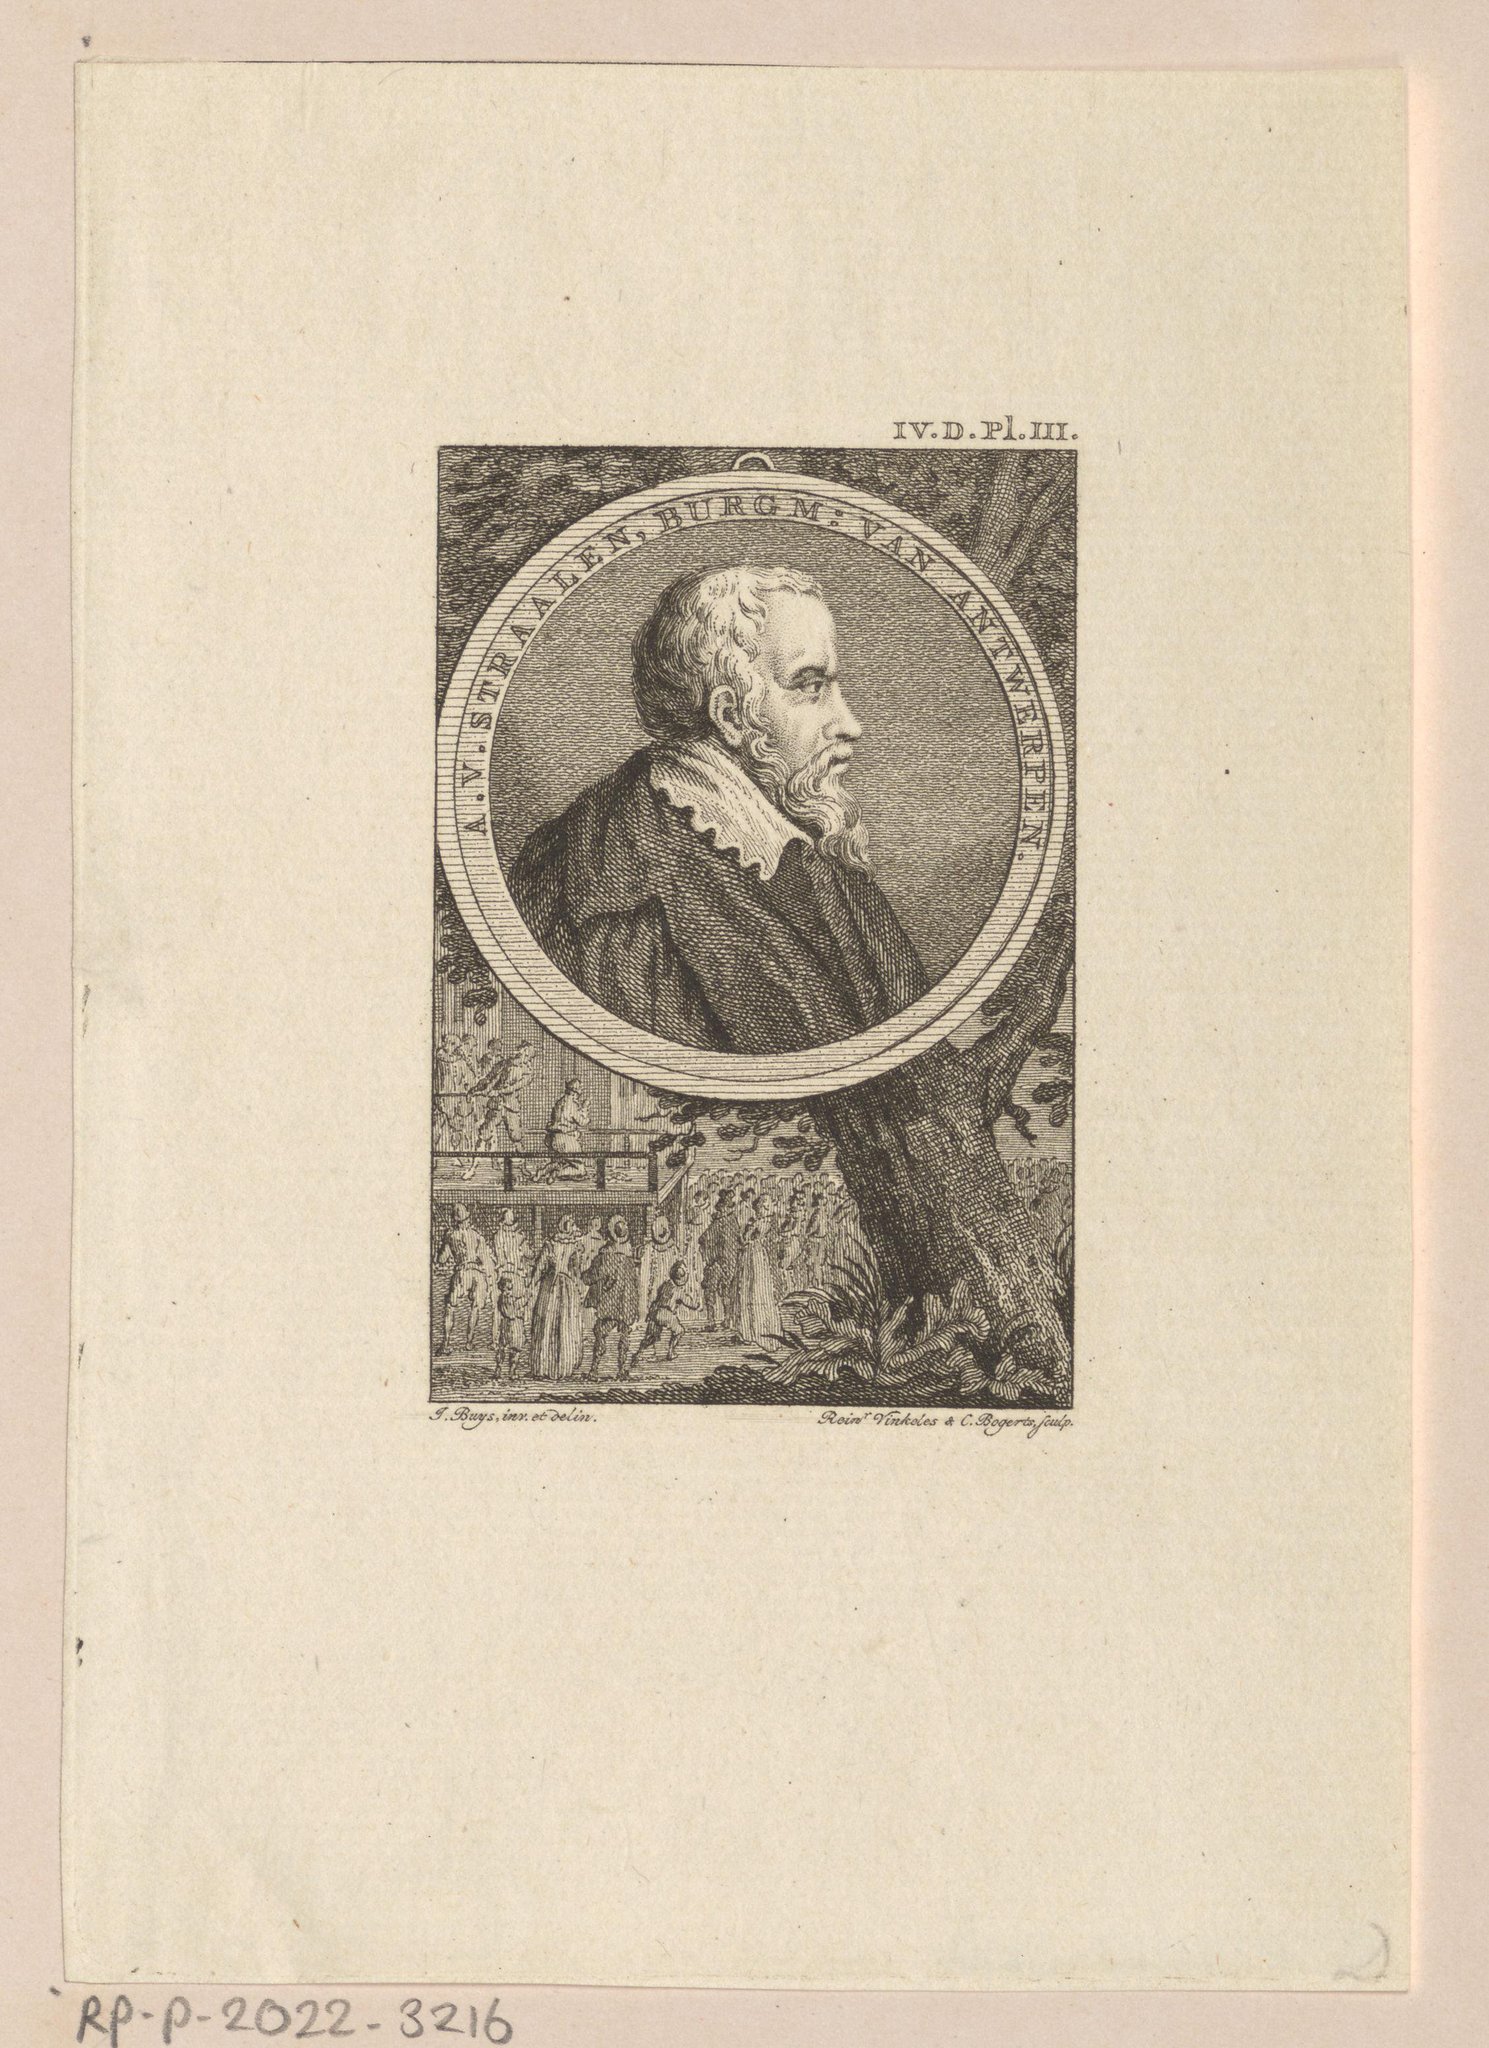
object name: print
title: Portret van Antoon van Stralen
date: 1784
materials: paper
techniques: etching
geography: amsterdam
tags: antwerp, mayor, burgomaster, historical persons, on the scaffold or place of execution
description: Prent waarschijnlijk uit: Fokke, Jan. Geschiedenissen der Vereenigde Nederlanden voor de vaderlandsche jeugd. Amsterdam: Johannes Allart, 1784, dl. 4.